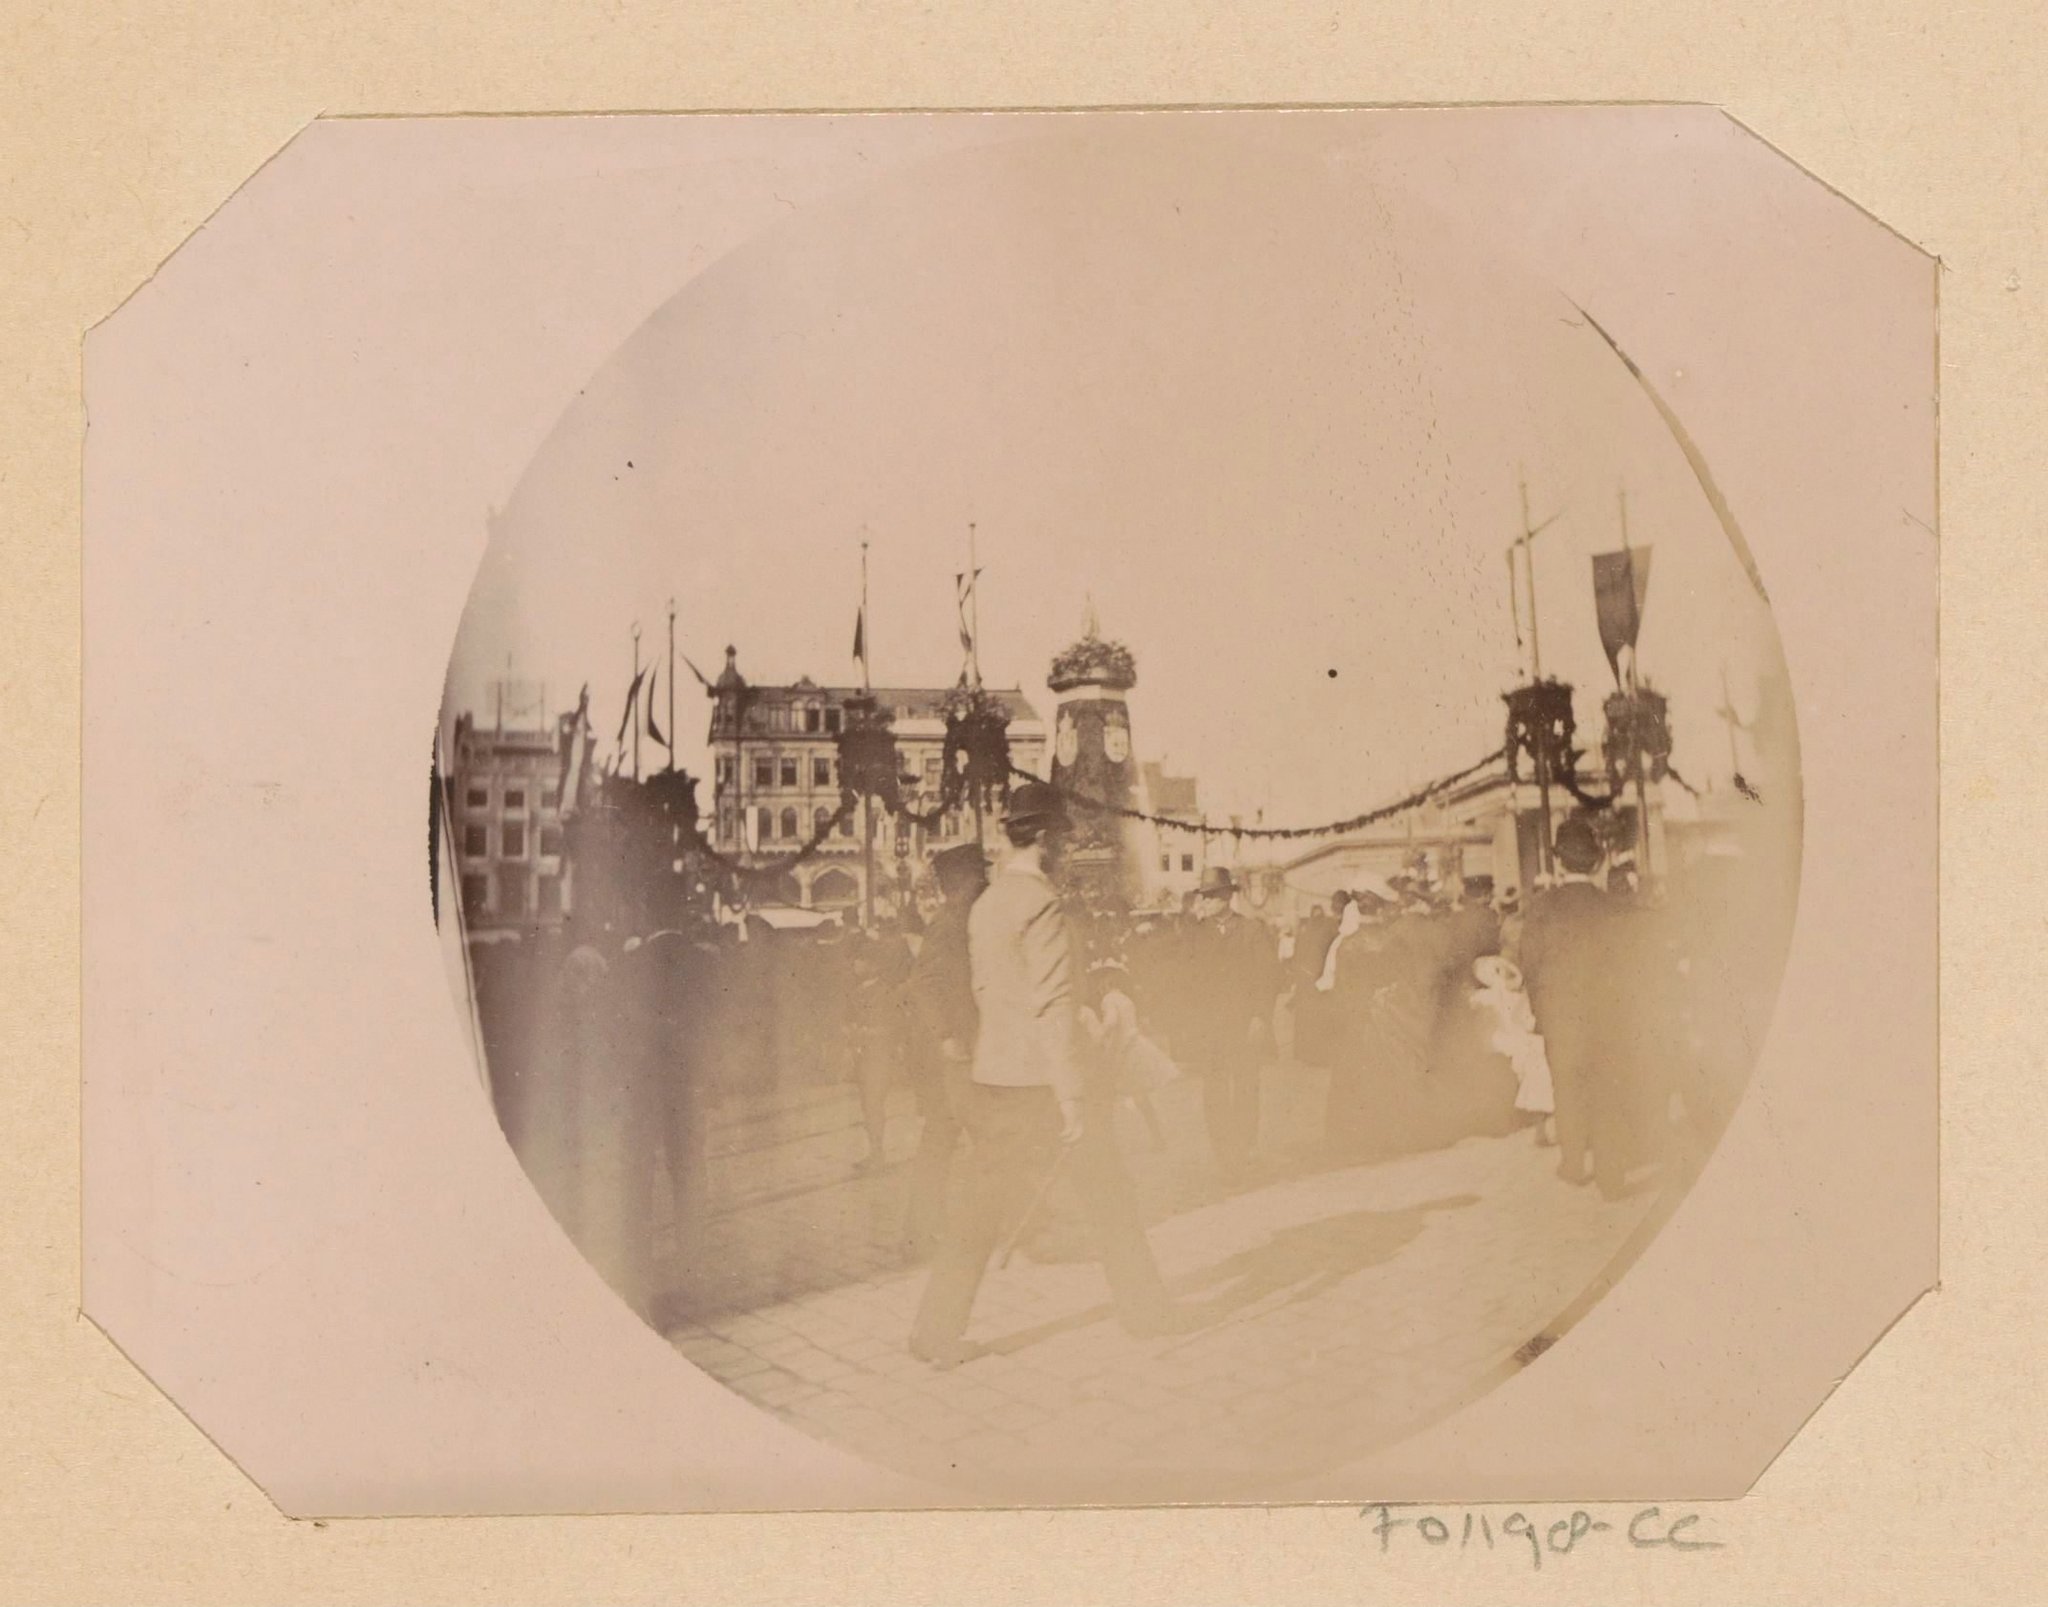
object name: photograph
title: Gezicht op de Dam tijdens het bezoek van keizer Wilhelm II van Duitsland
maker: johanna margaretha piek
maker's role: fotograaf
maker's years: 1870-1947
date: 1891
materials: paper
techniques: gelatin silver print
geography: amsterdam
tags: square, place, circus, etc., imperial celebrations 1891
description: In het midden het feestelijk versierde Monument ter herinnering aan den volksgeest van 1830-1831. Rechts de beurs van Zocher.